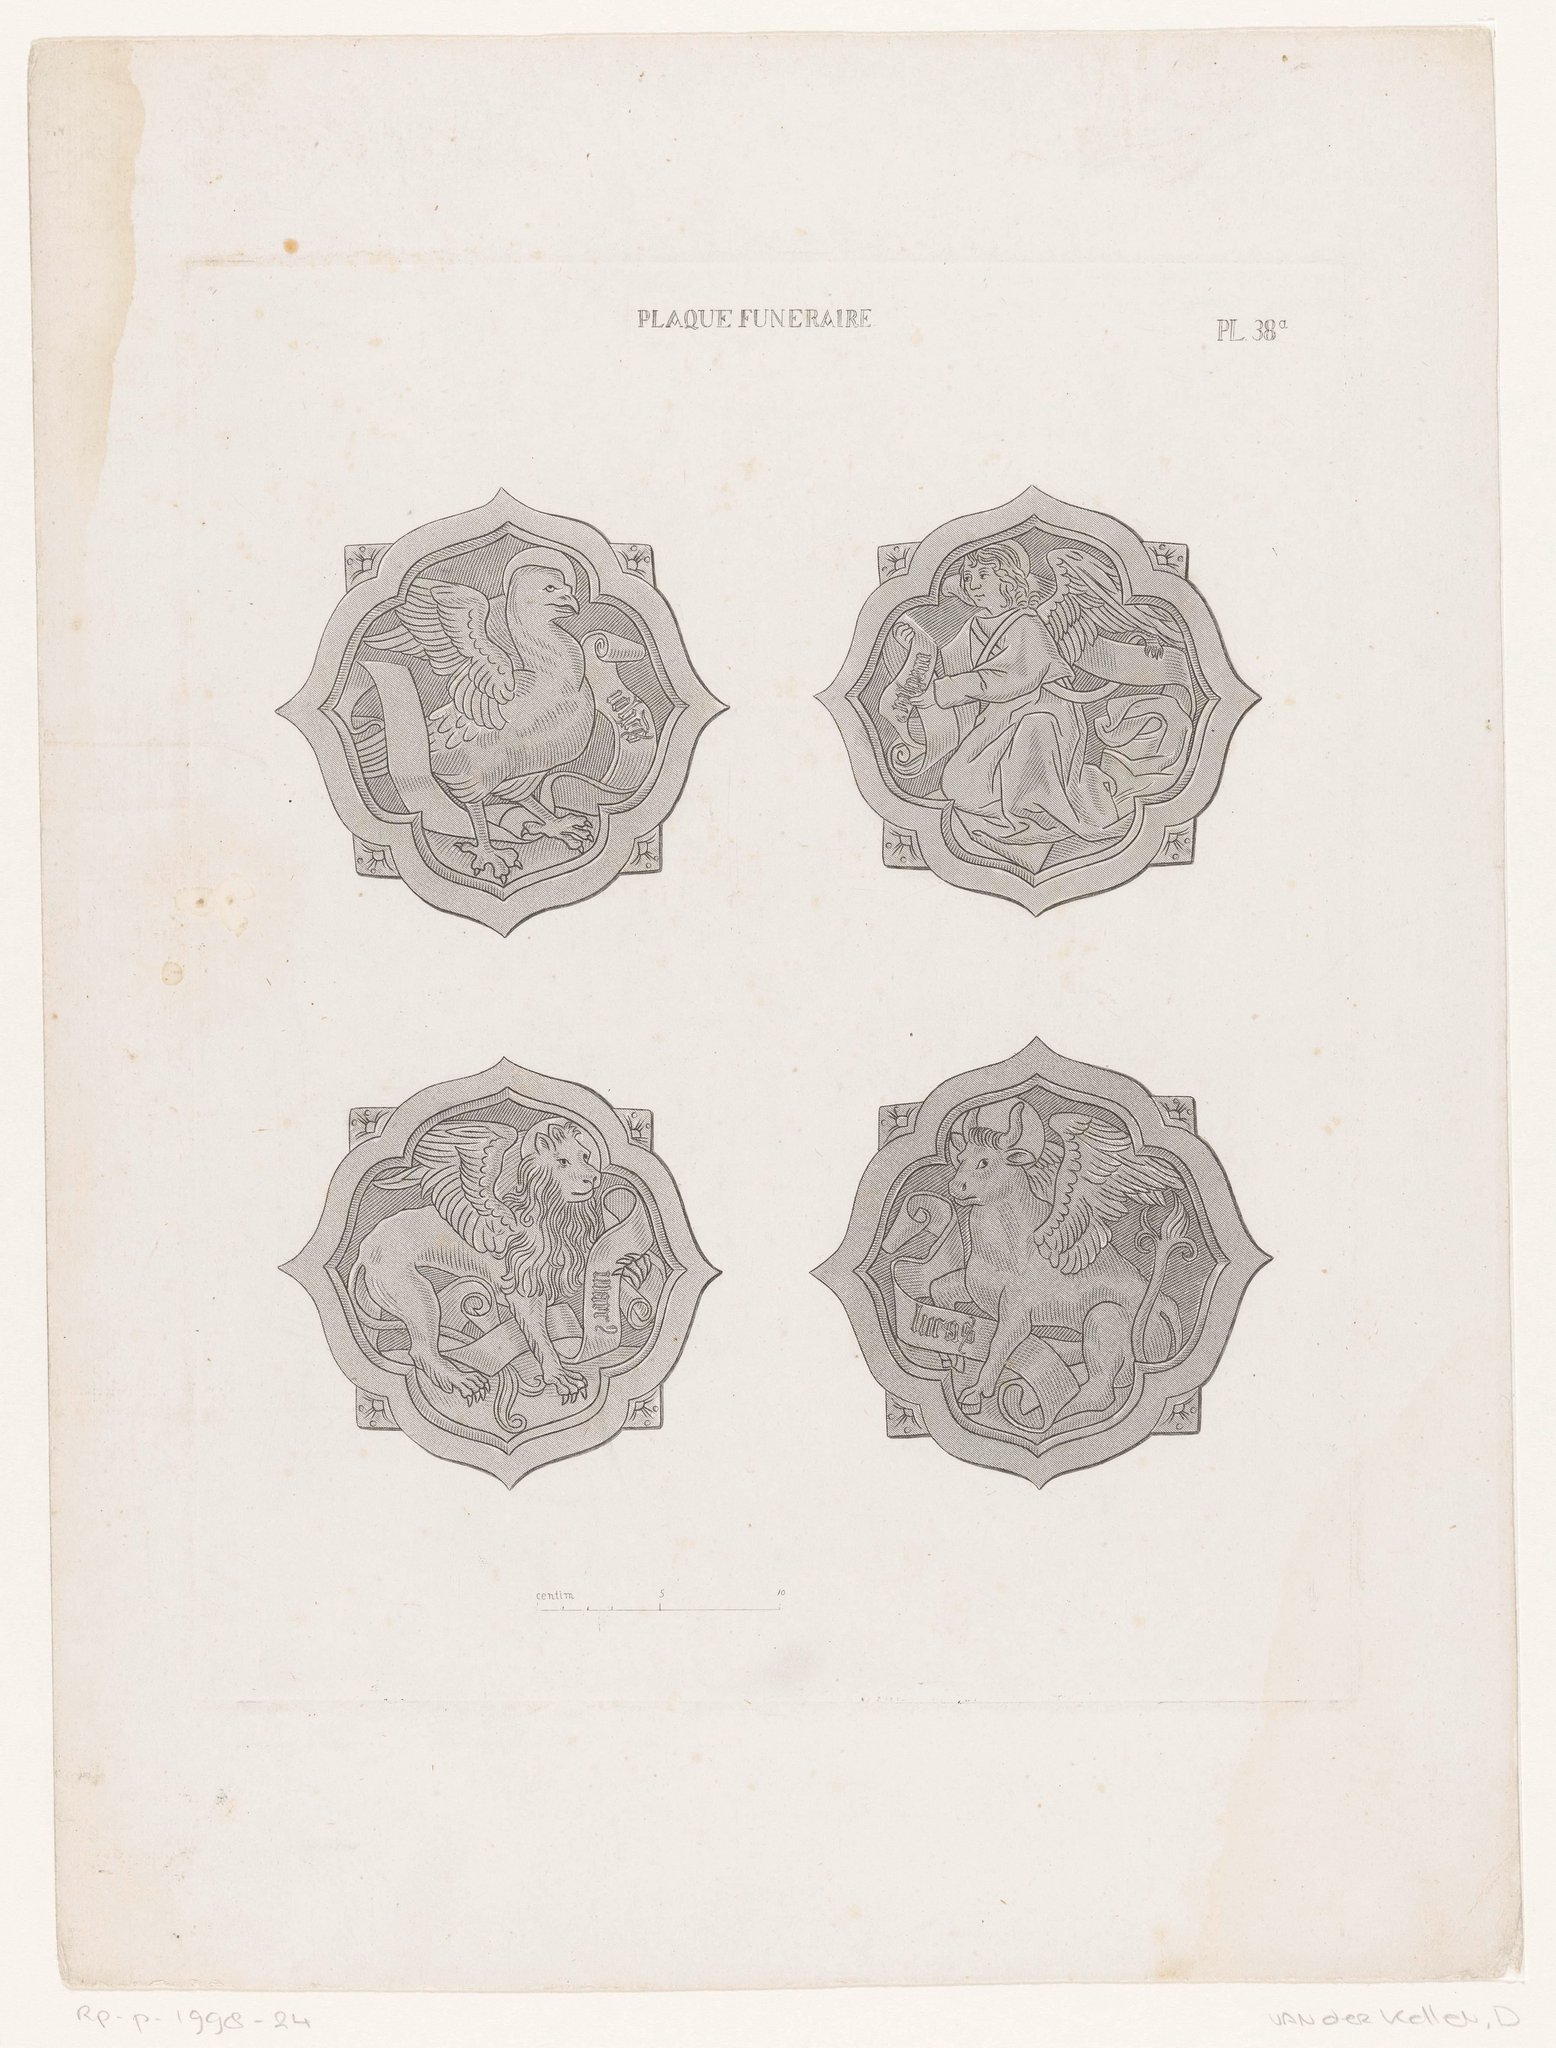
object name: print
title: Platen van grafzerk Gijsbert Willemsz. Raet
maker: david van der kellen (1804-1879)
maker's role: die cutter, draughtsman, print maker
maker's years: 1804-1879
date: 1865-1878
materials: paper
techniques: etching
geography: netherlands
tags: gravestone, tombstone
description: Vier geelkoperen platen van de grafzerk van Gijsbert Willemsz. Raet, priester aan de St. Johanneskerk te Gouda. Met symbolen van de vier evangelisten.